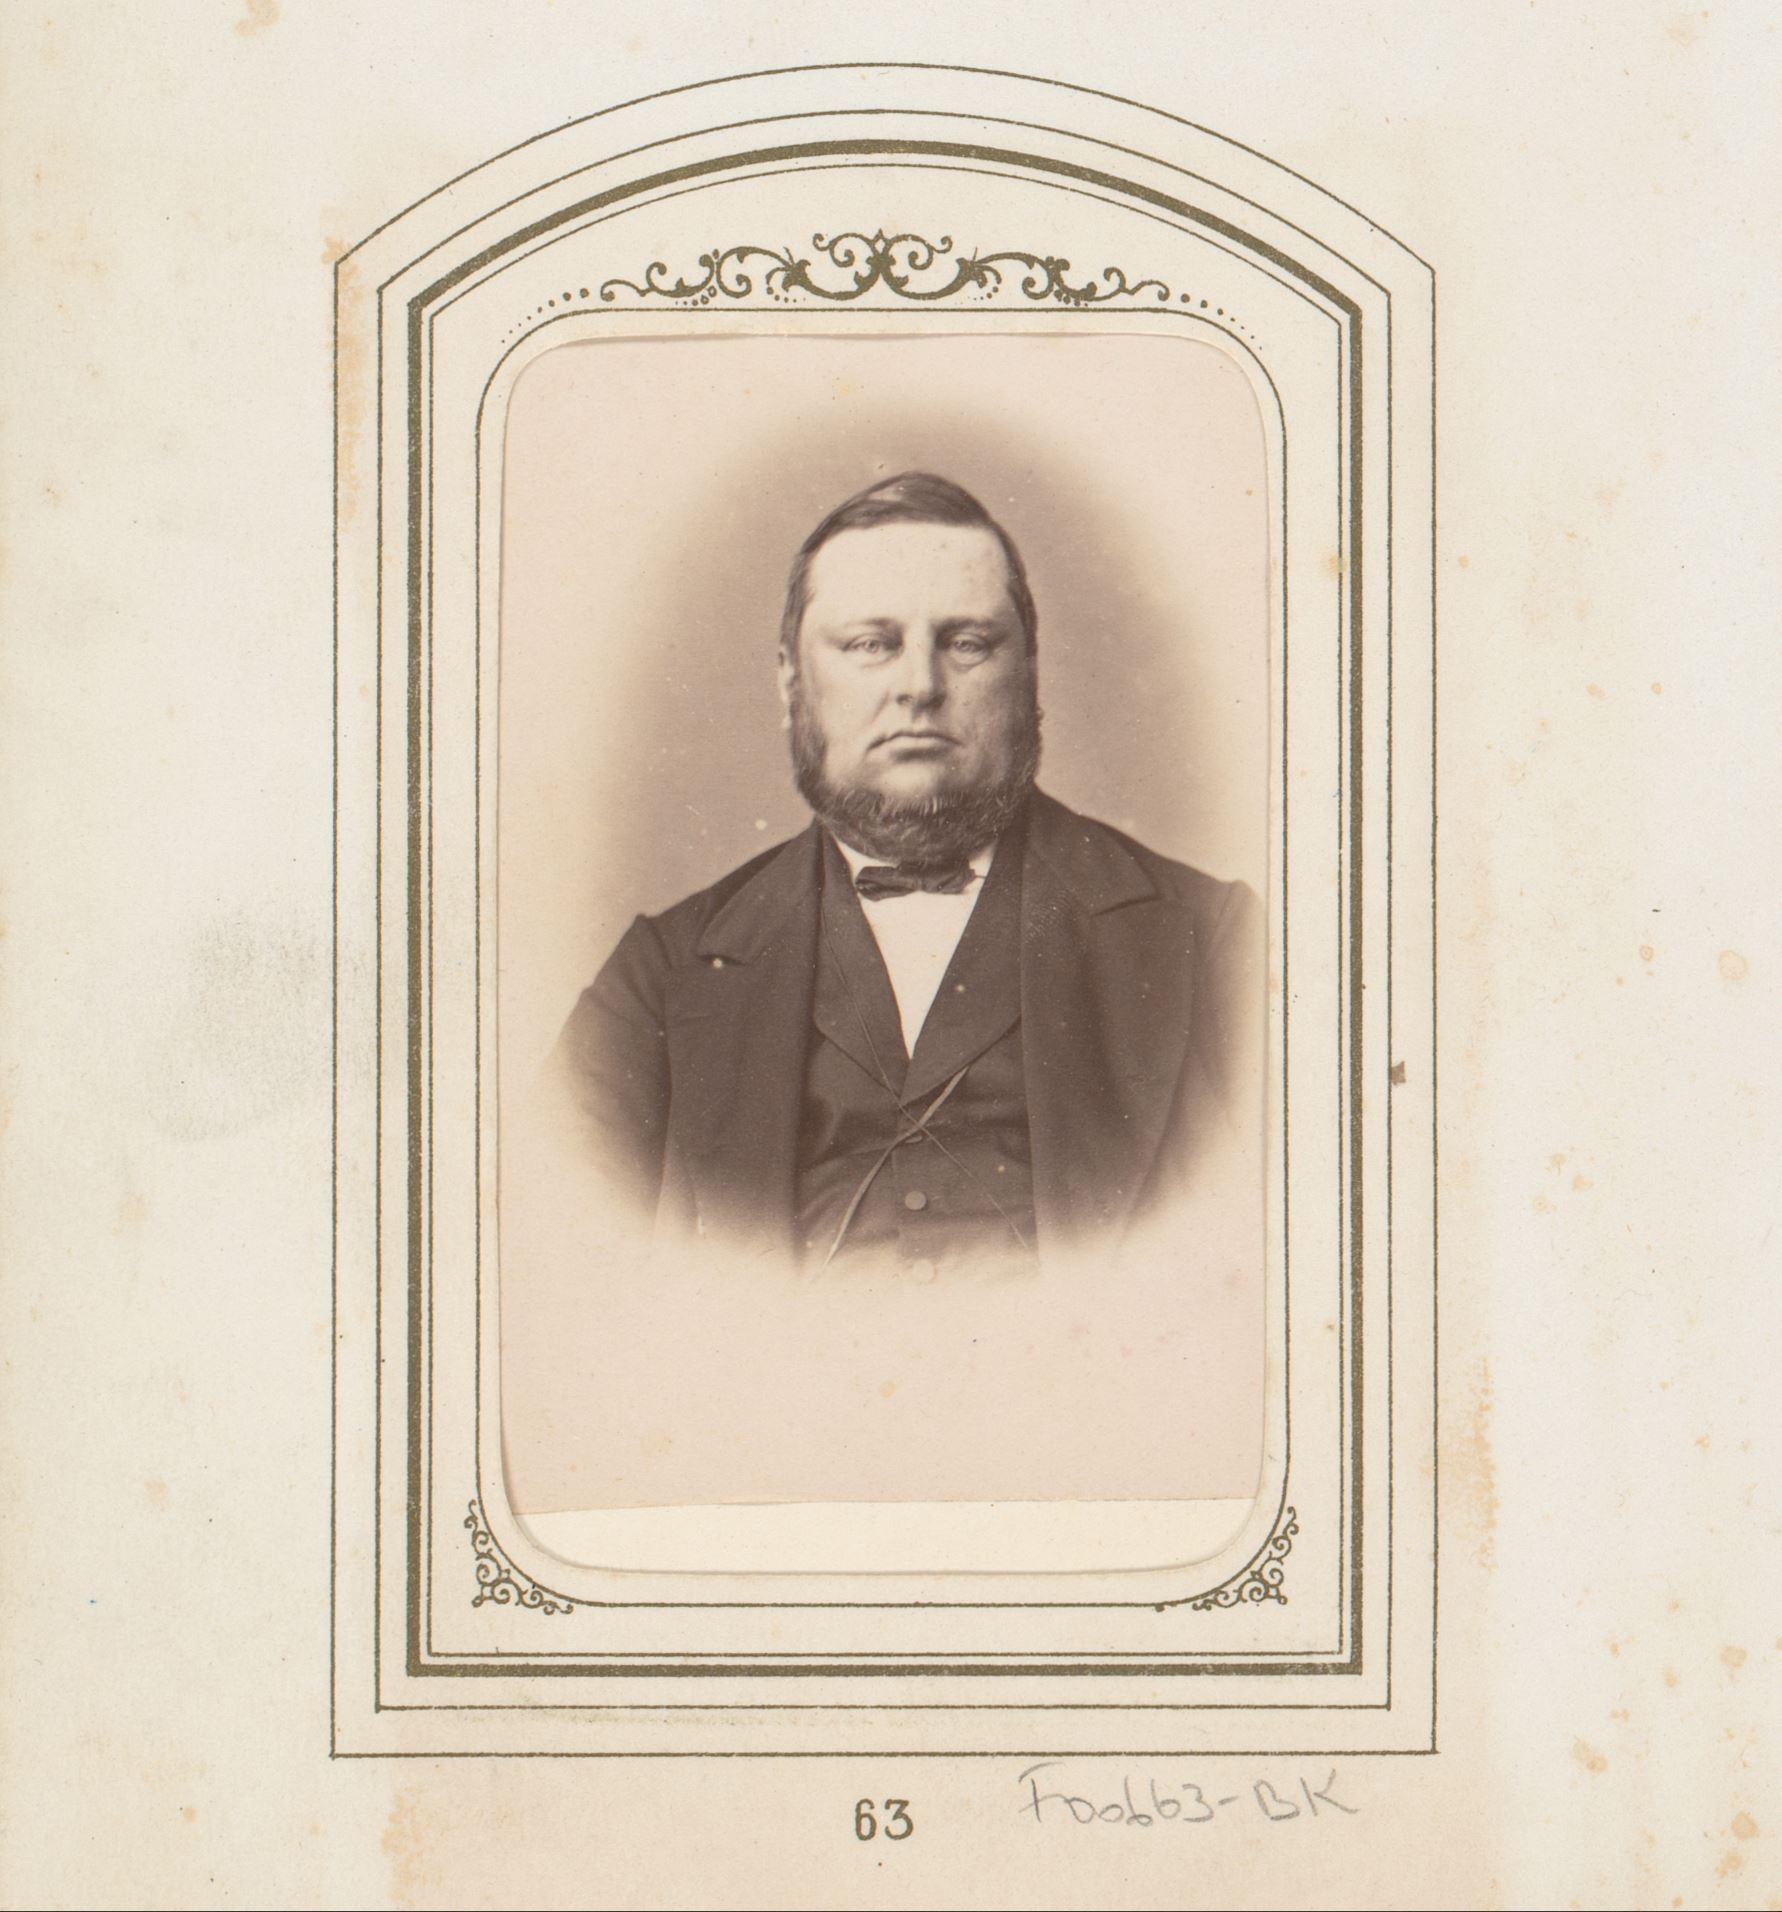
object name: photograph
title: Portret van een man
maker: roelof loots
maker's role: fotograaf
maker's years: 1814-1898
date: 1860-1880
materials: cardboard, photographic support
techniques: albumen print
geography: medemblik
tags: historical persons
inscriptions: inscription: ‘Photographie van R. Loots/ Medemblik’, number: ‘63’